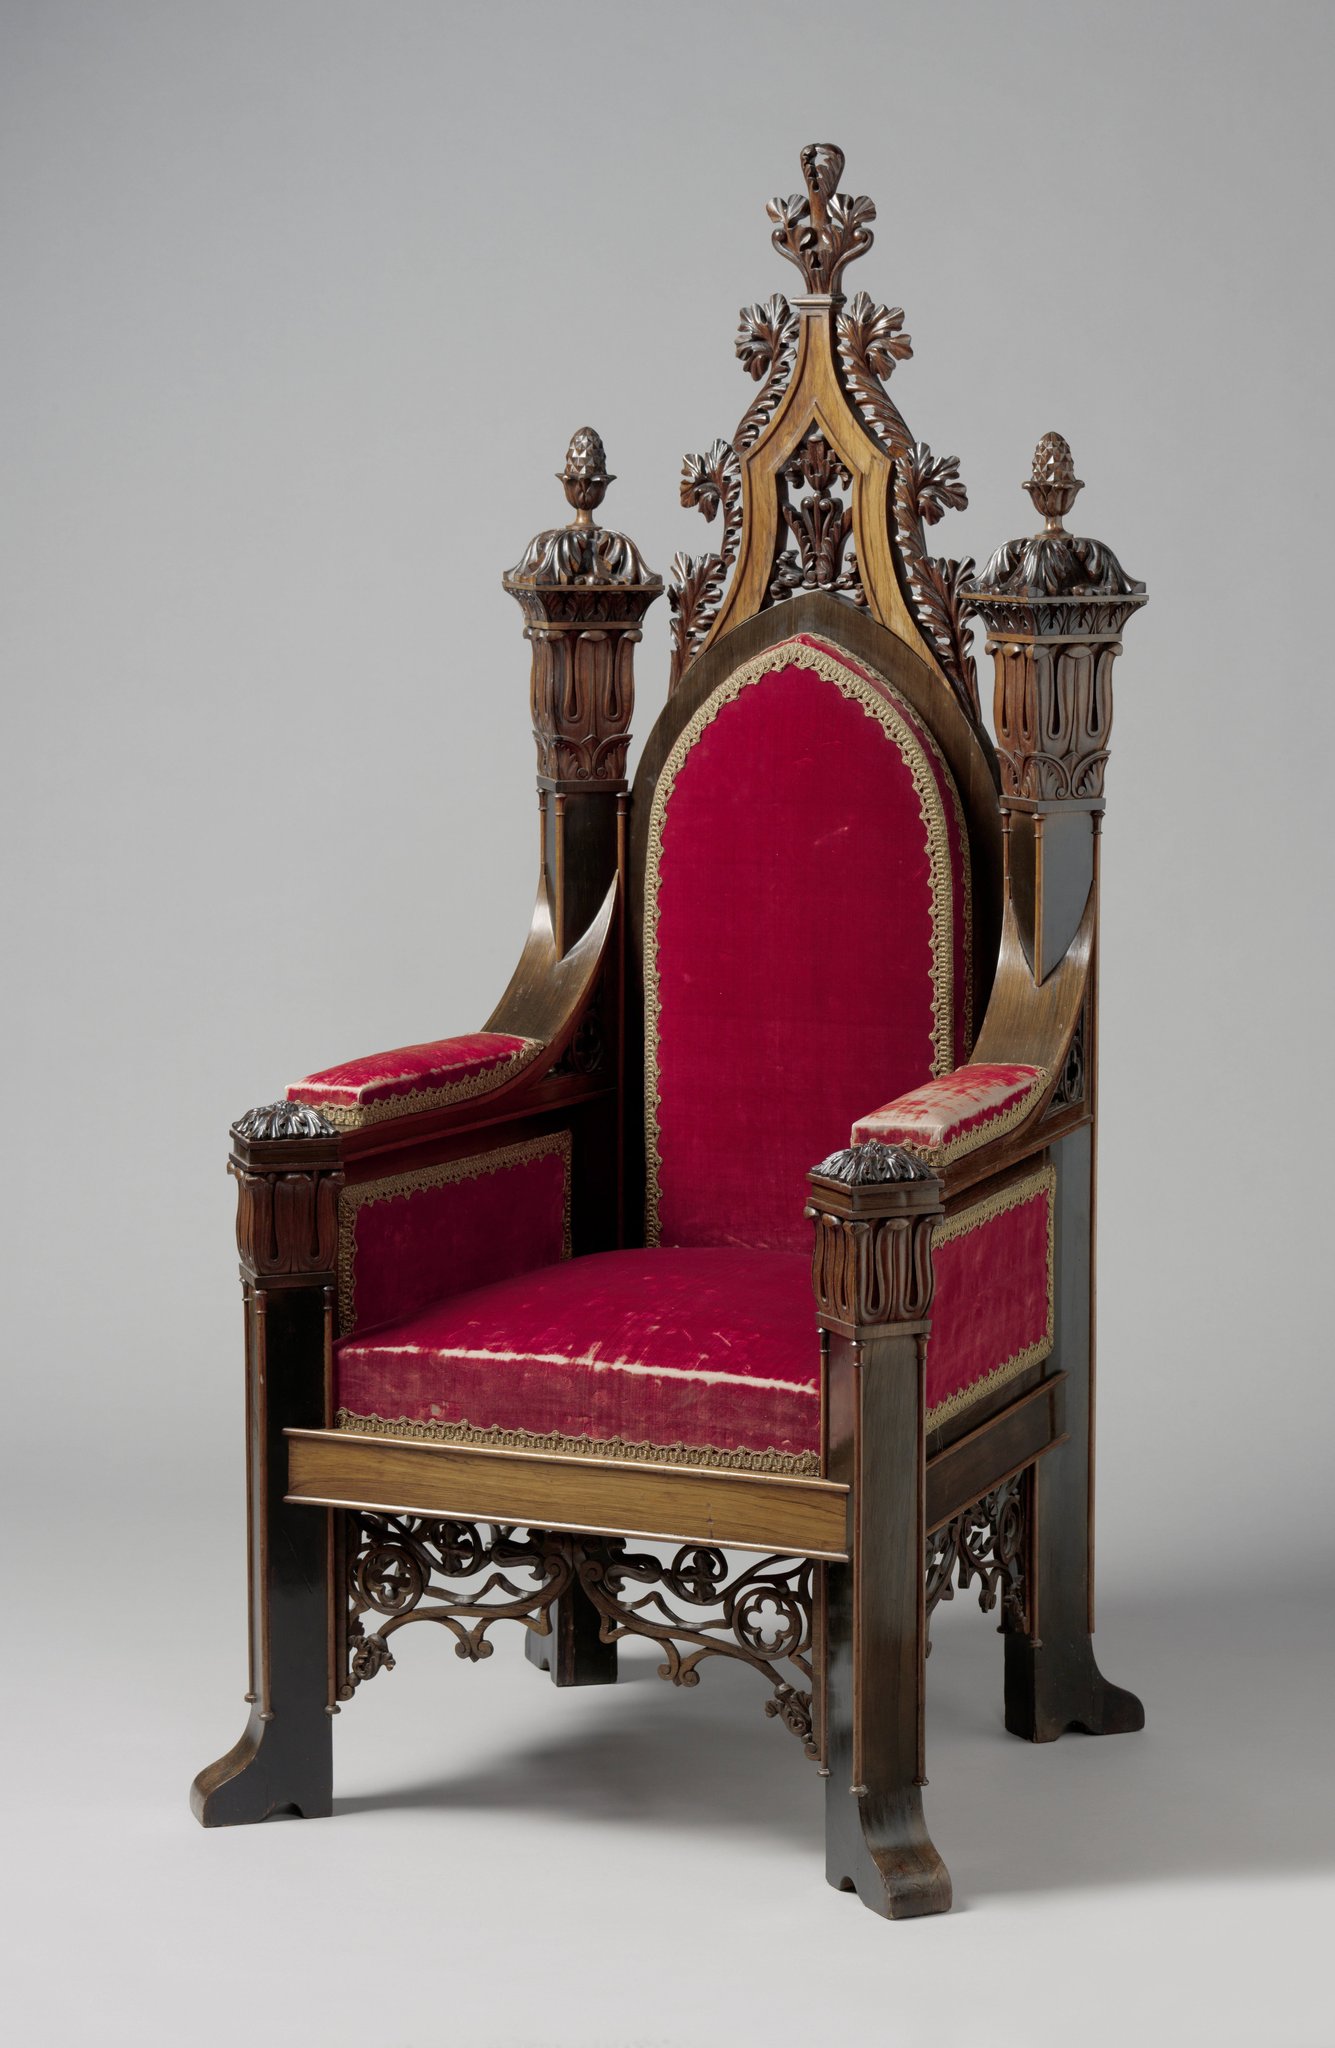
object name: troonzetel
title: Troonzetel van palissanderhout bekleed met rood fluweel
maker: carel breytspraak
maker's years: 1808-1810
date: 1850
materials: gold thread, wood, velvet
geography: netherlands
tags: the hague, emma (queen consort of the netherlands)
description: Troonzetel van palissanderhout met notenhout en bekleed met rood fluweel. Op de bekleding een passement van gouddraad.